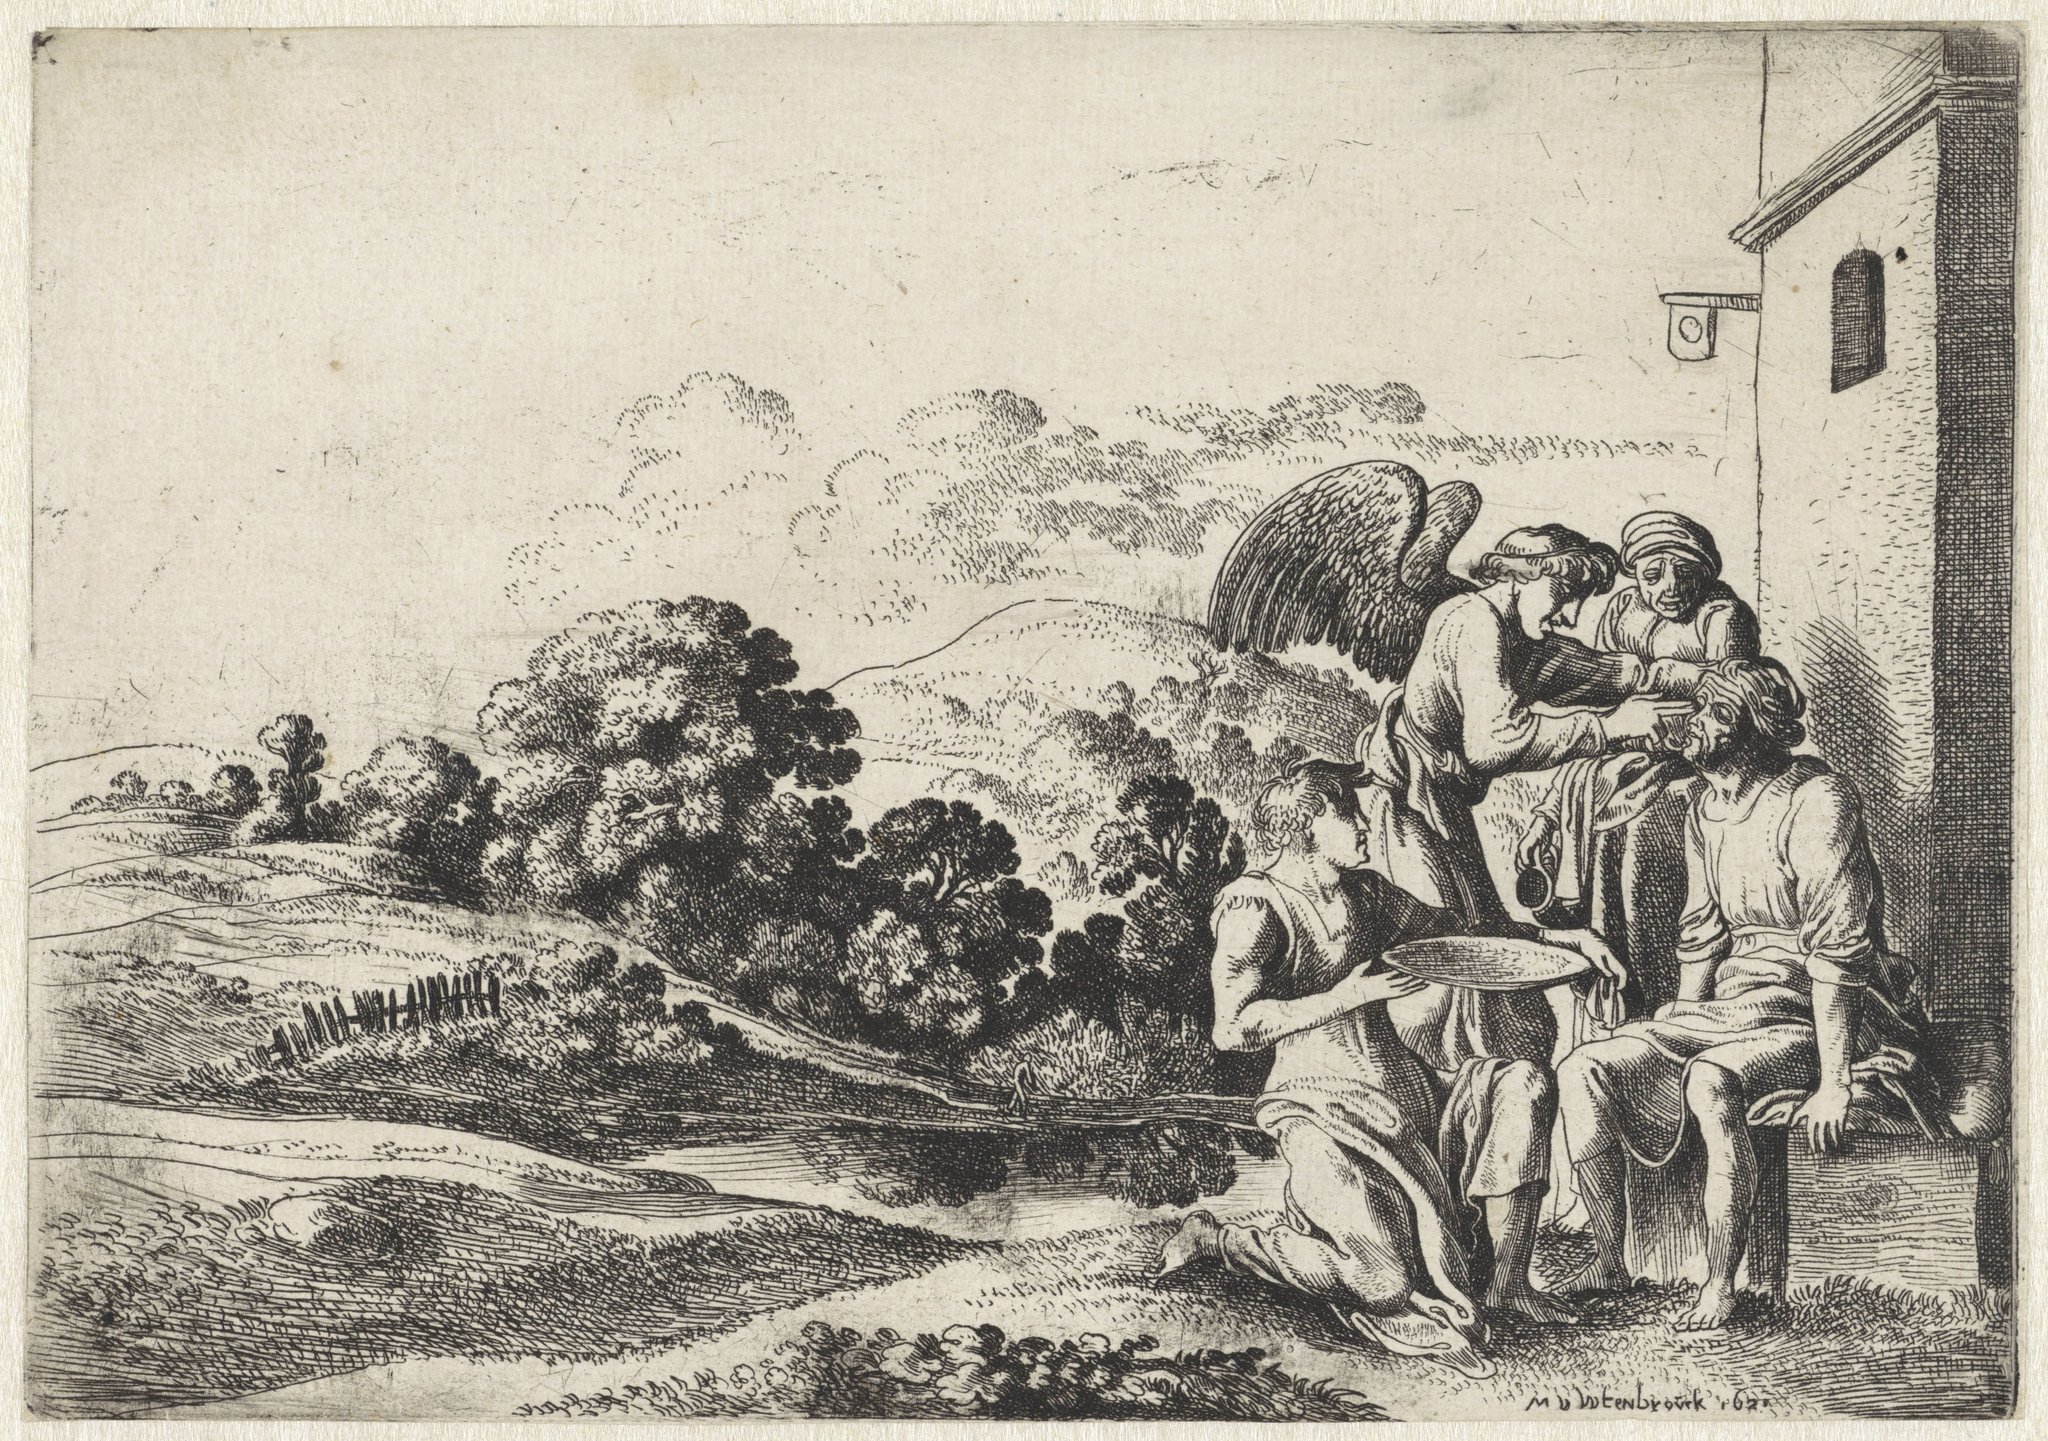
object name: print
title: Het verhaal van Tobias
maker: moyses van wtenbrouck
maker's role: painter, print maker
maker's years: 1590-1647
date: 1621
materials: paper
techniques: engraving, etching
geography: the hague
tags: the healing of tobit: tobias puts the gall of the fish on his father's eyes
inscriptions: collector's mark: Lugt 2228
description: Met de gal van een vis geneest Tobias zijn vaders blindheid. Naast hem de engel Rafaël en Anna, de moeder van Tobias.